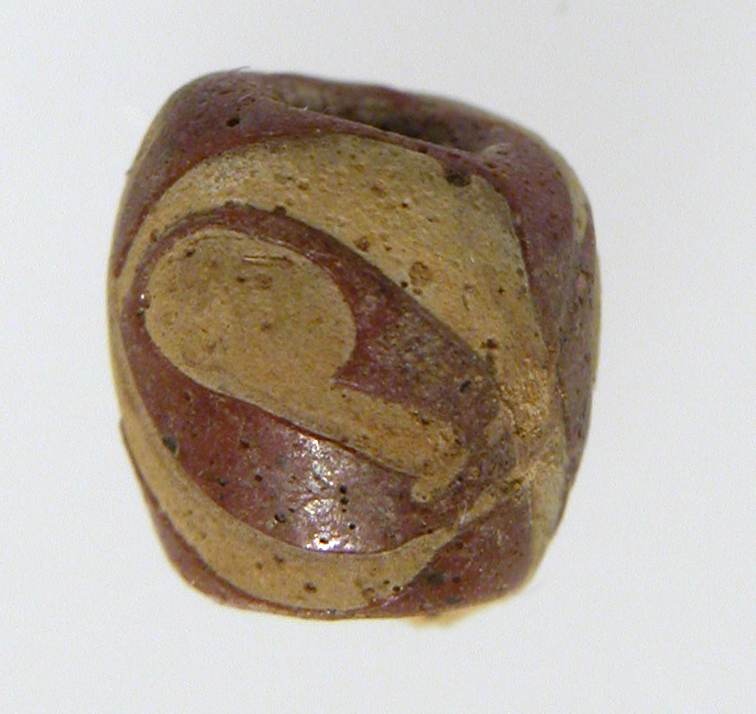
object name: bead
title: Small Bead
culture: frankish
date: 500-600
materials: glass